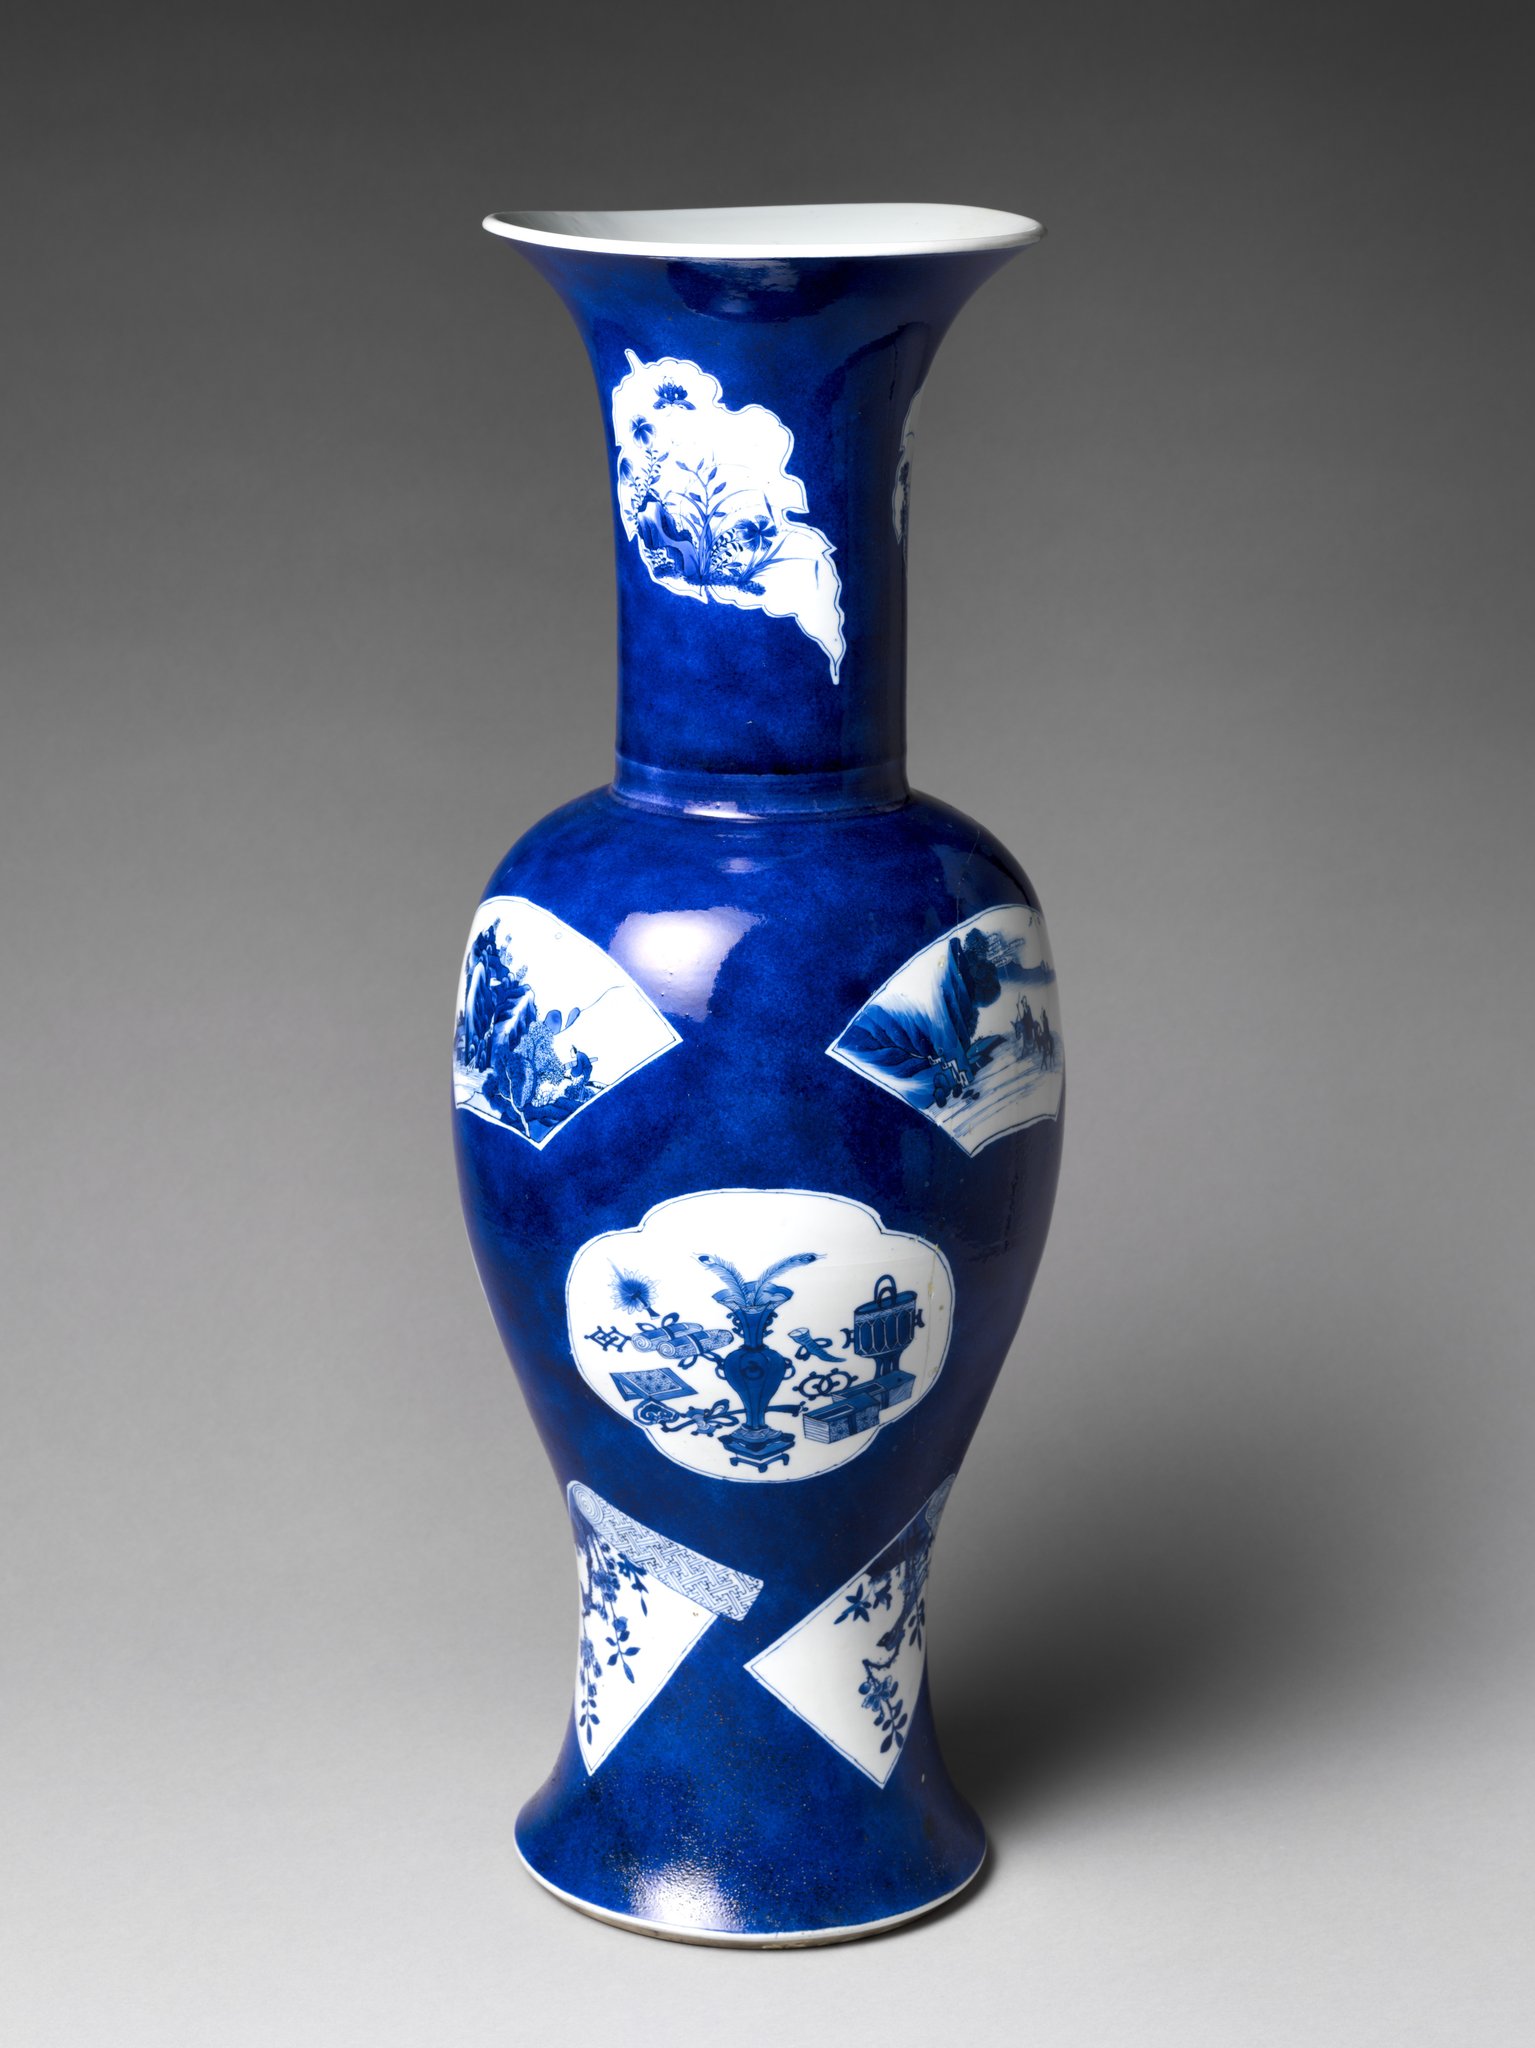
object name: vase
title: Vase with Flowers and Scholar’s Implements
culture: chinese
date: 1701-1733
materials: cobalt, glaze, porcelain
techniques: painting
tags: flowers